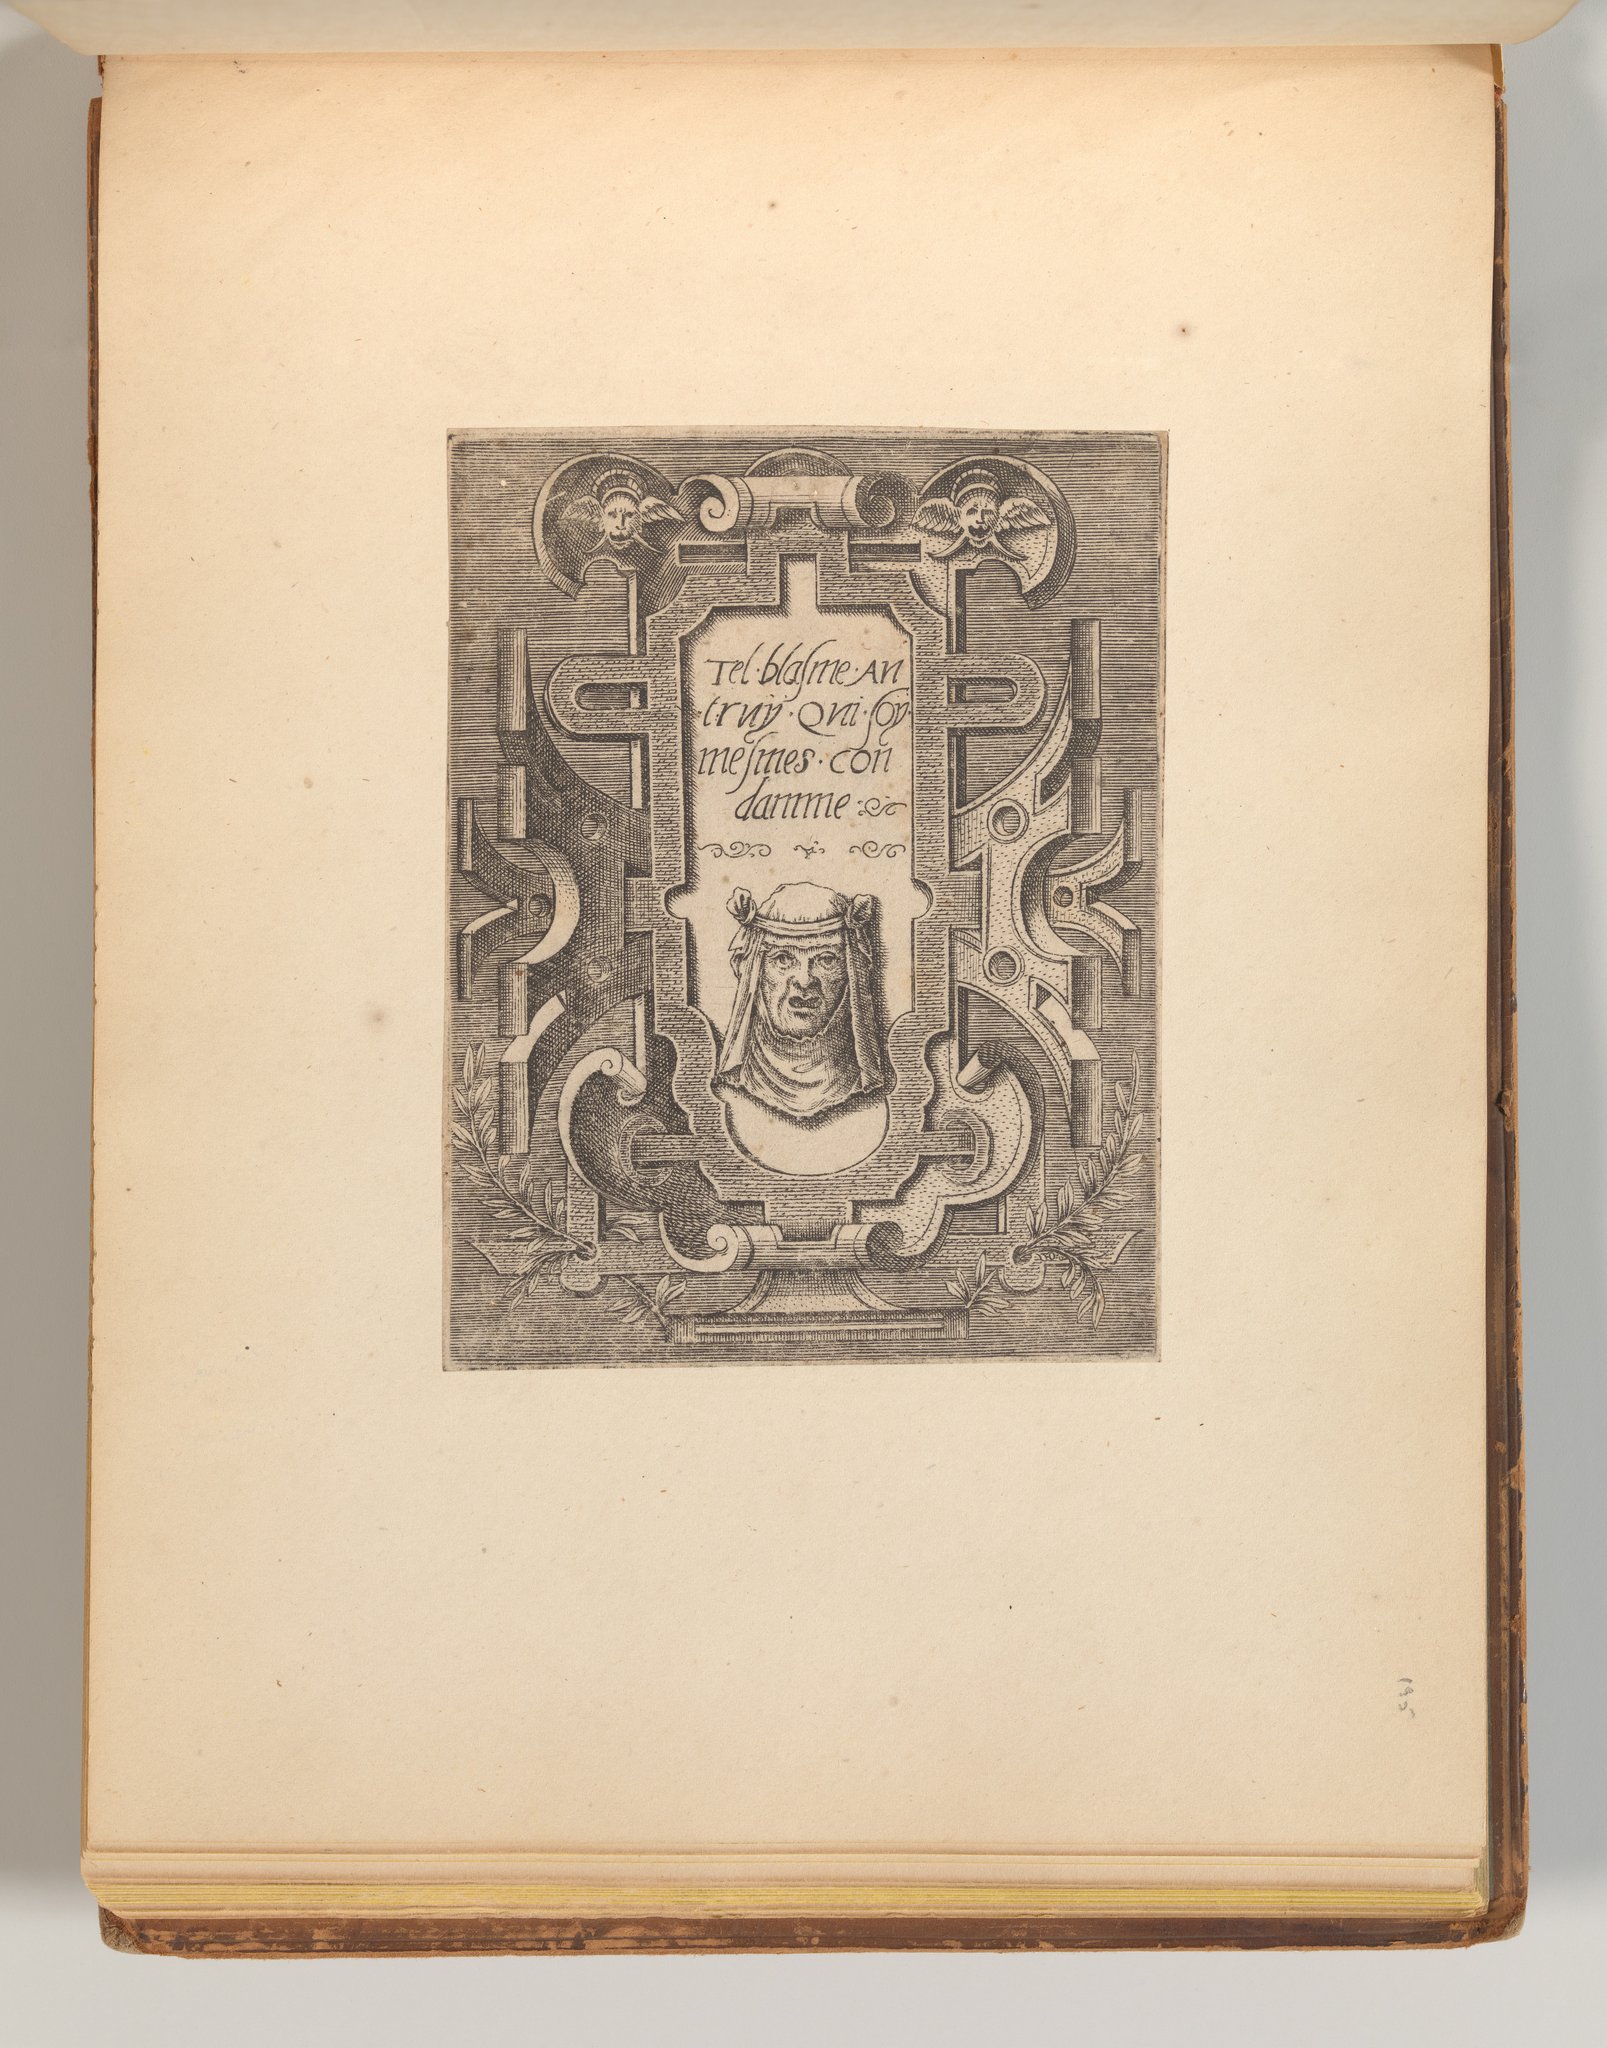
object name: album print ornament architecture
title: Series of Cartouches, in: Targhe ed altri ornati di varie e capricciose invenzioni (Cartouches and other ornaments of various and capricious invention, page 38)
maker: cornelis bos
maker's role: artist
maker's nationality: netherlandish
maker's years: 1510-1556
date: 1545-1560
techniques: engraving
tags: cartouches